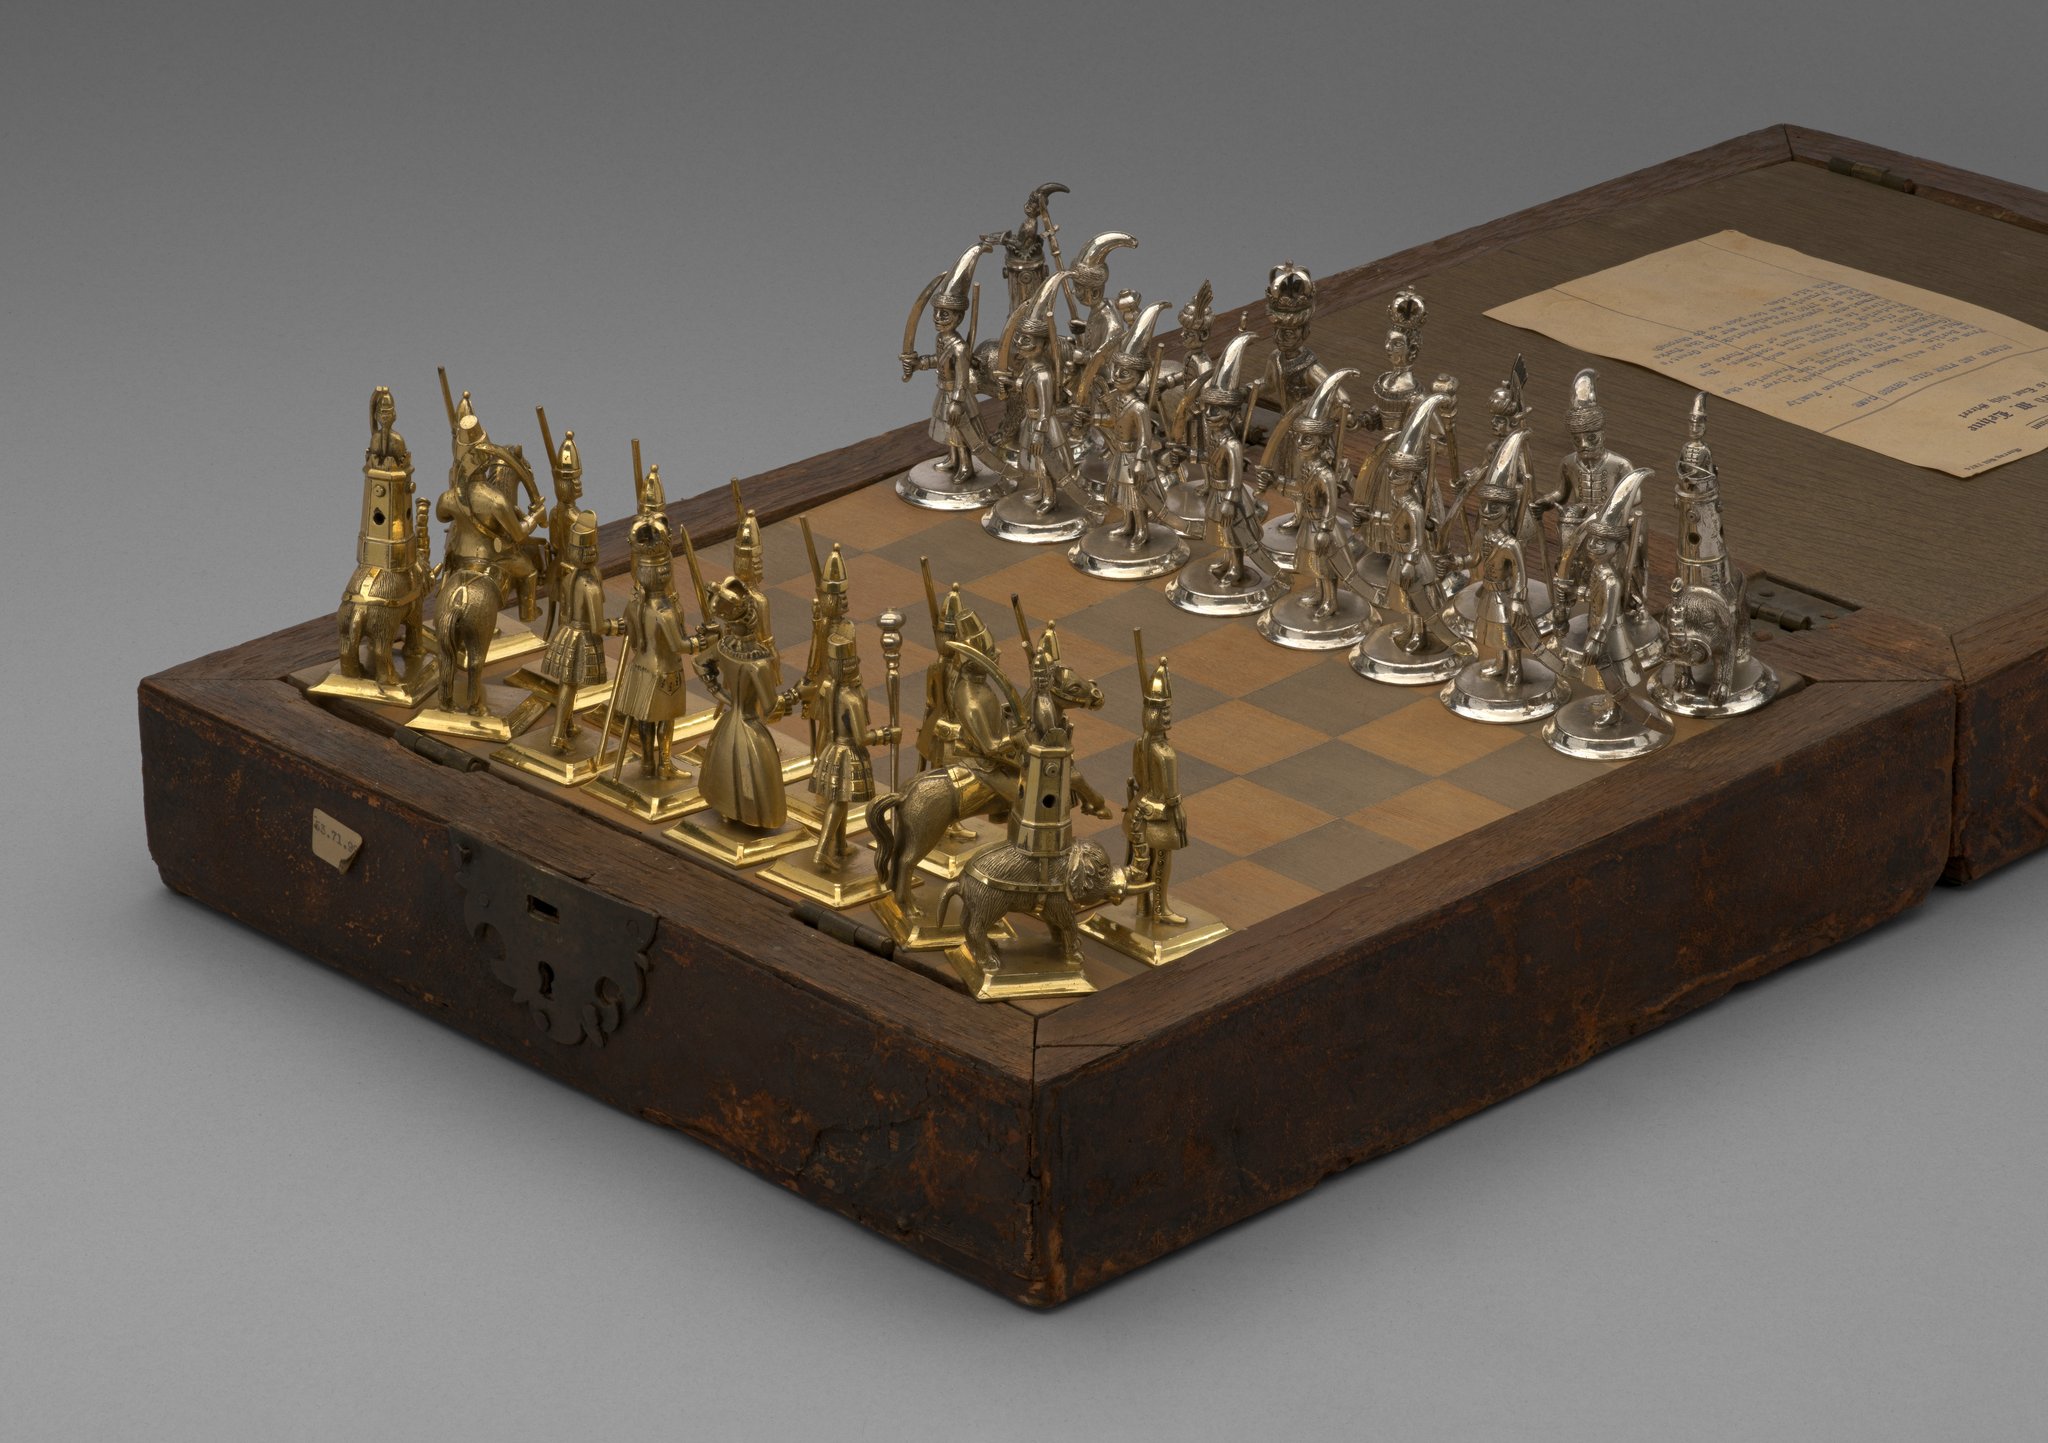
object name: chess set and box board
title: Chess set and box-board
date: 1801-1900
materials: metal, silver gilt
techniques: silvered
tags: chess